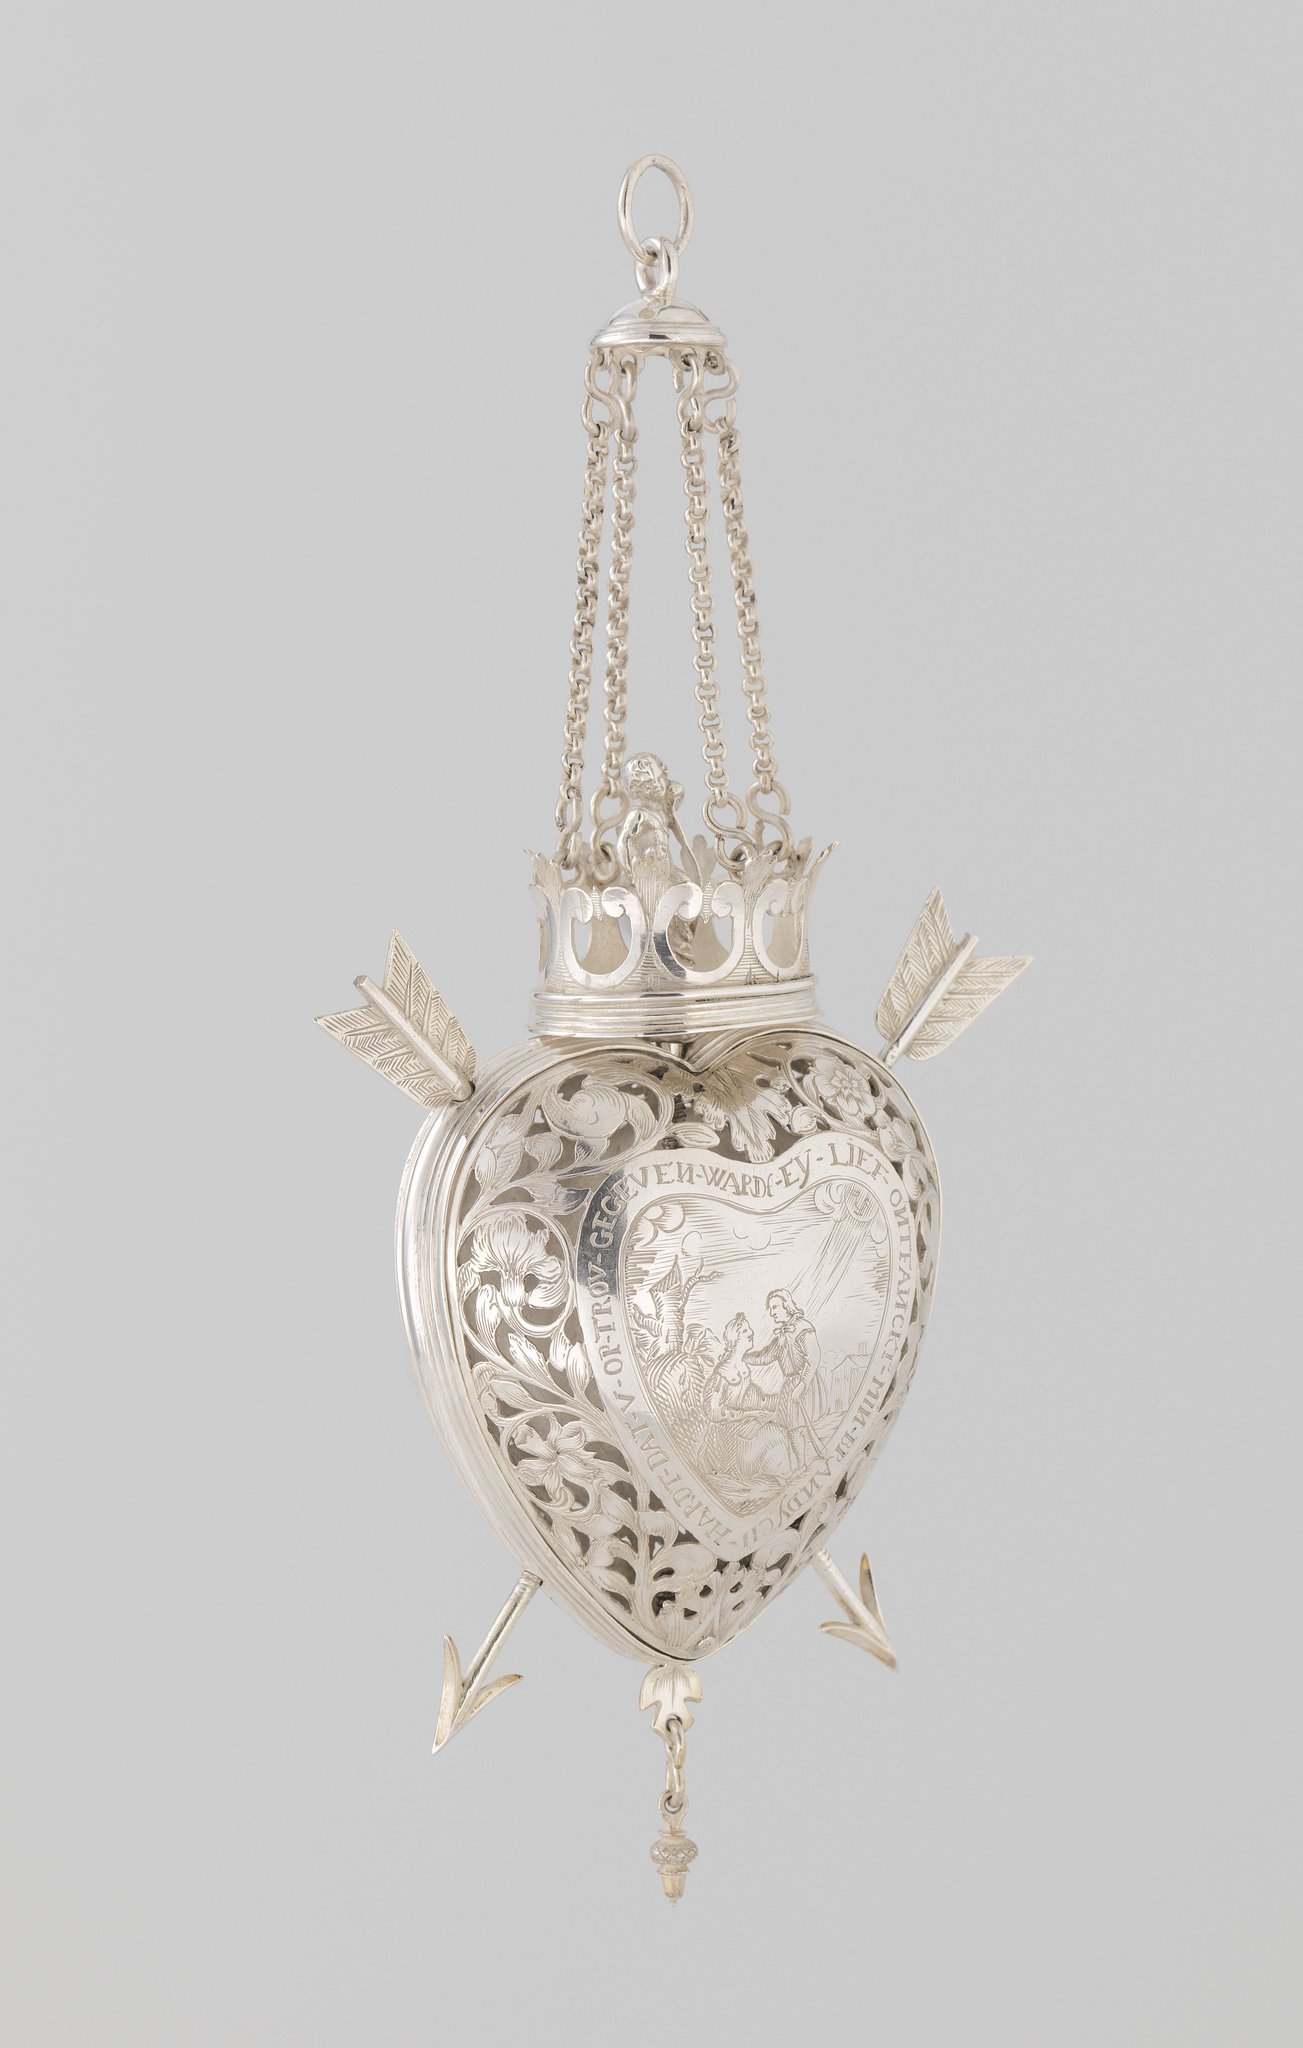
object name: bruidshart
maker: Anonymous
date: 1625-1674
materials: silver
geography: friesland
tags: couple of lovers, profane heart symbolism ~ love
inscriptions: inscription: ‘Aen Godes wedt, wy syn verbonden, Sonder dat, leven wy in sonden.’, inscription: ‘Ey lief ontfanckt myn brandych hardt, Dat u op trou gegeven wardt.’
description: Bride's heart. Silver. Friesland, c. 1650.